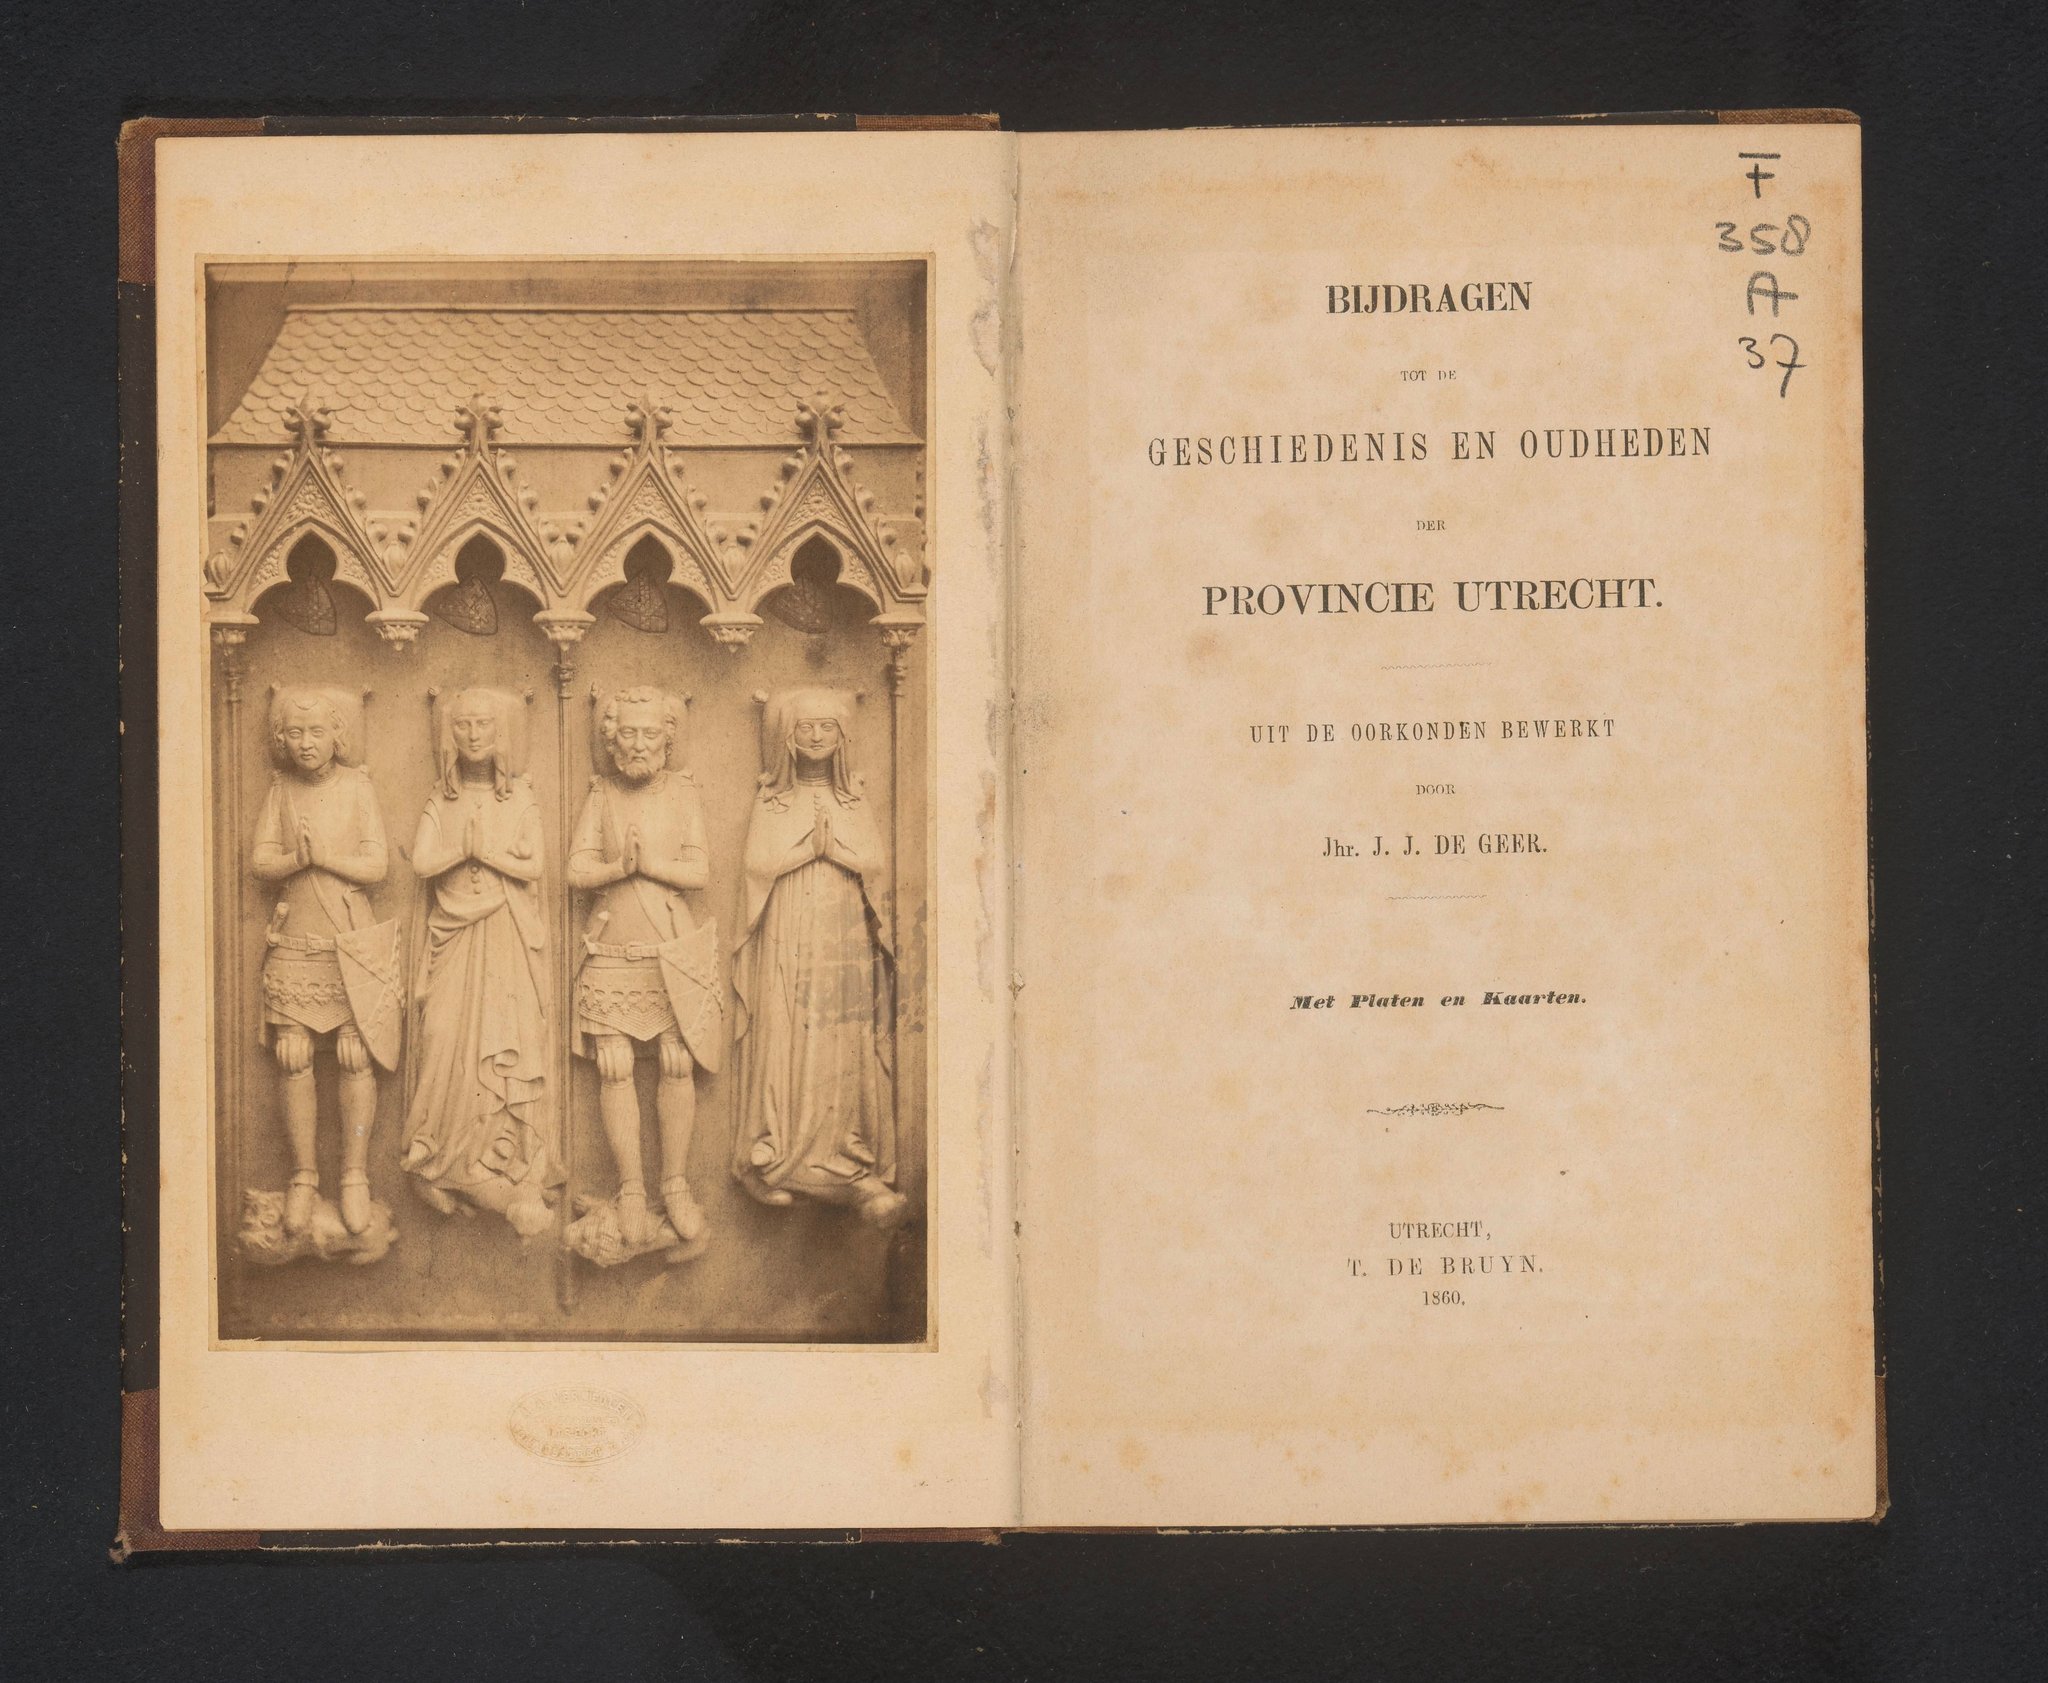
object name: photograph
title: Reliëf met vier figuren, detail van het praalgraf in de Oude Sint-Nicolaaskerk in Ijsselstein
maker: abraham adrianus vermeulen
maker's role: painter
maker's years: 1817-1894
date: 1855-1860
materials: photographic support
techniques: albumen print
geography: ijsselstein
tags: grave, tomb, sculpture